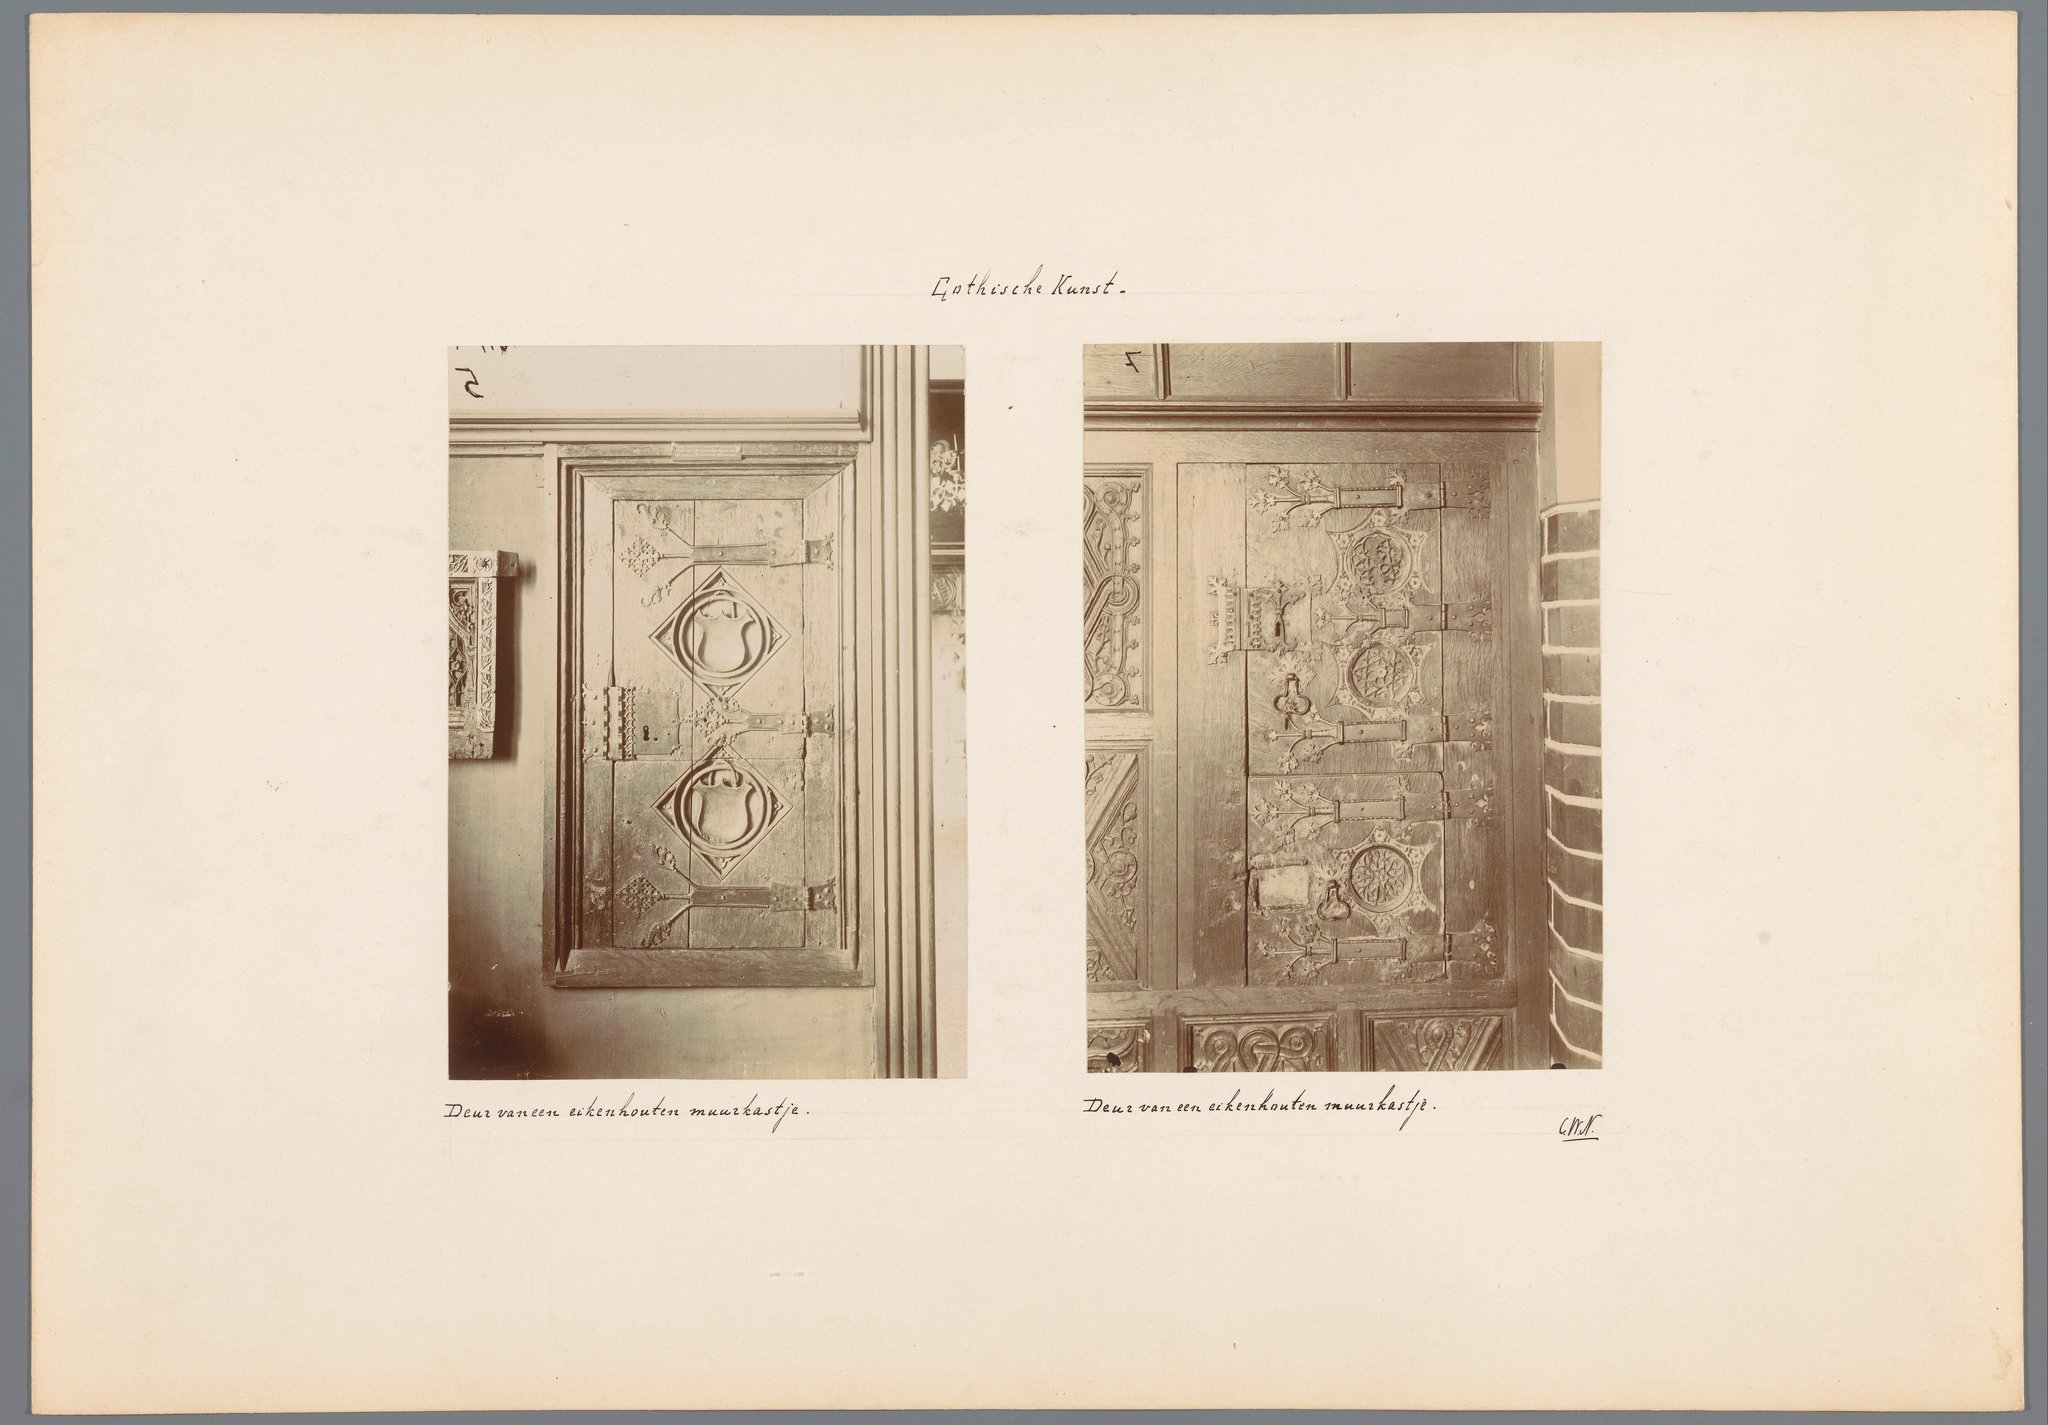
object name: photograph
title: Overzicht van twee eikenhouten kastdeuren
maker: Anonymous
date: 1875-1900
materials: cardboard, photographic support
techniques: daylight paper print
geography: netherlands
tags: interior of the house, closed door, sculpture (+ relief ~ sculpture), netherlands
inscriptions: number: ‘5’, collector's mark: ‘KUNSTNIJVERHEIDSCHOOL QUELLINUS AMSTERDAM FRANS HALSSTRAAT 14.’, inscription: ‘Gothische Kunst. Deur van een eikenhouten muurkastje.’, name: ‘CWN.’, collector's mark: ‘INSTITUUT VOOR KUNST- NIJVERHEIDSONDERWIJS GABRIËL METSUSTRAAT No. 16. AMSTERDAM’, number: ‘7’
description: Links een eikenhouten deur van een muurkastje met wapenschilden gedecoreerd, rechts een eikenhouten deur van een muurkastje.